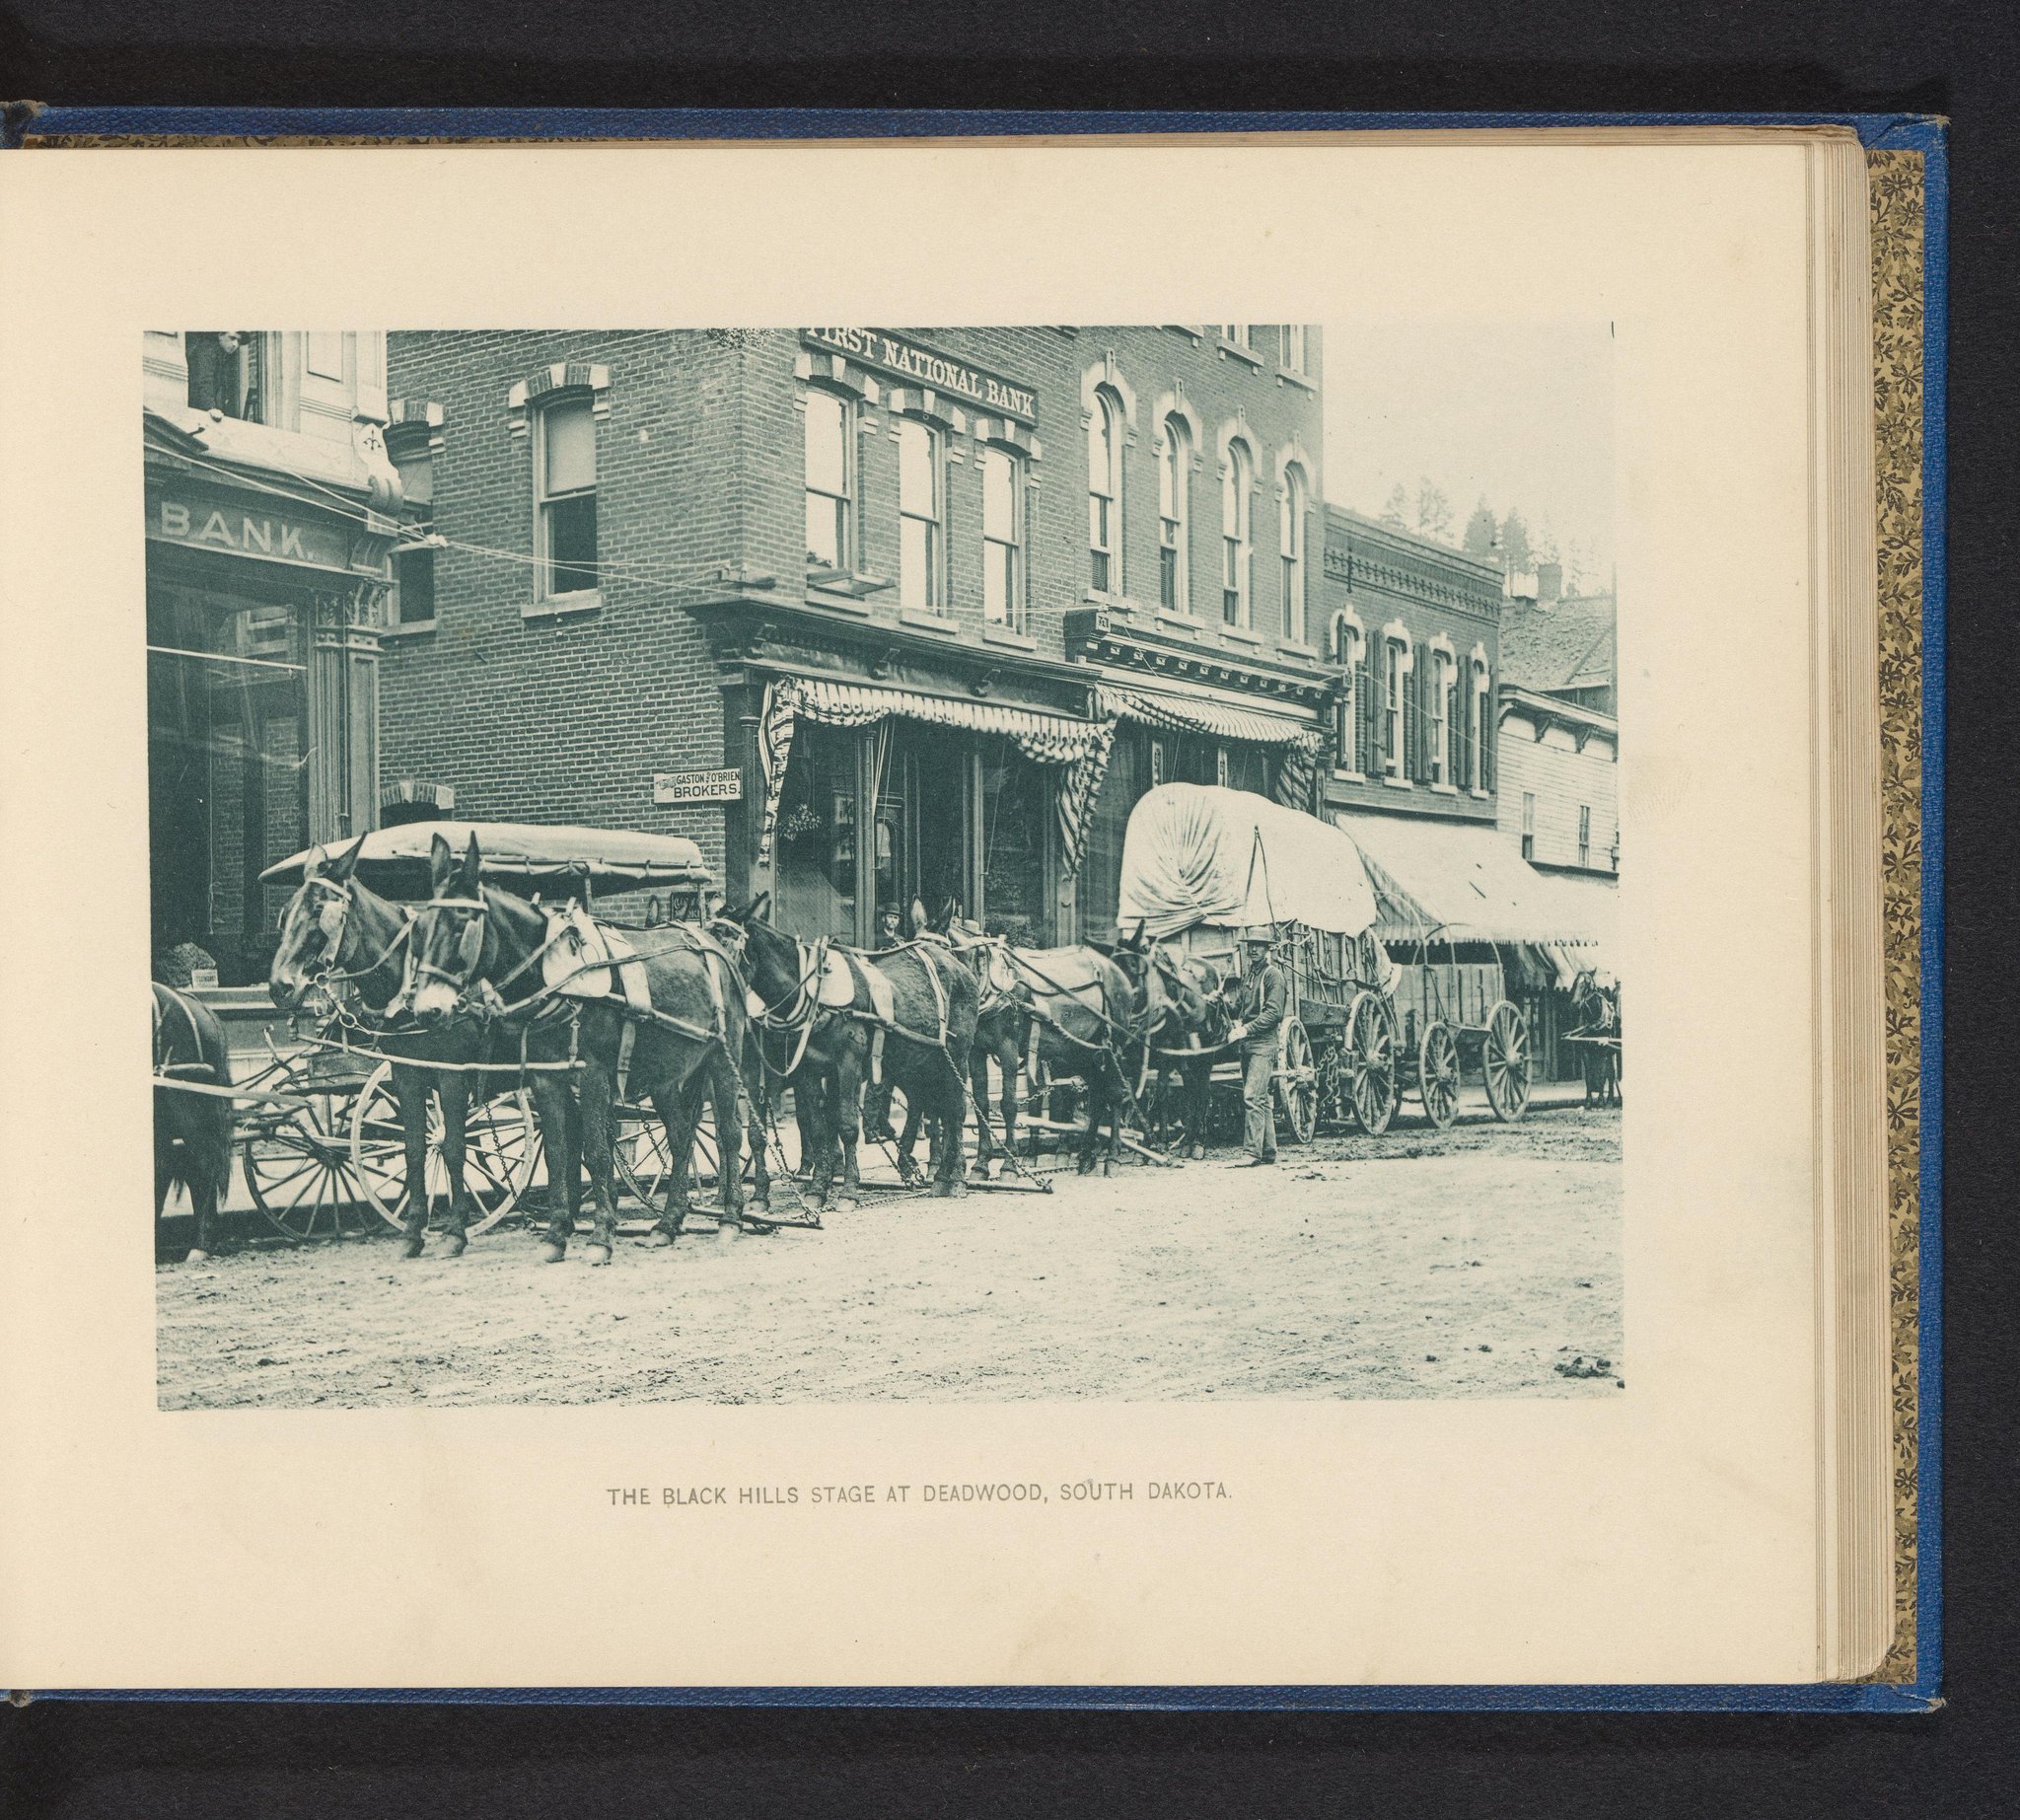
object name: photomechanical print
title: The Black Hills Stage at Deadwood, South Dakota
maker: Anonymous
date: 1883-1893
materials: paper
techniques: photograph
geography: deadwood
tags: four-wheeled, animal-drawn vehicle, e.g.: cab, carriage, coach